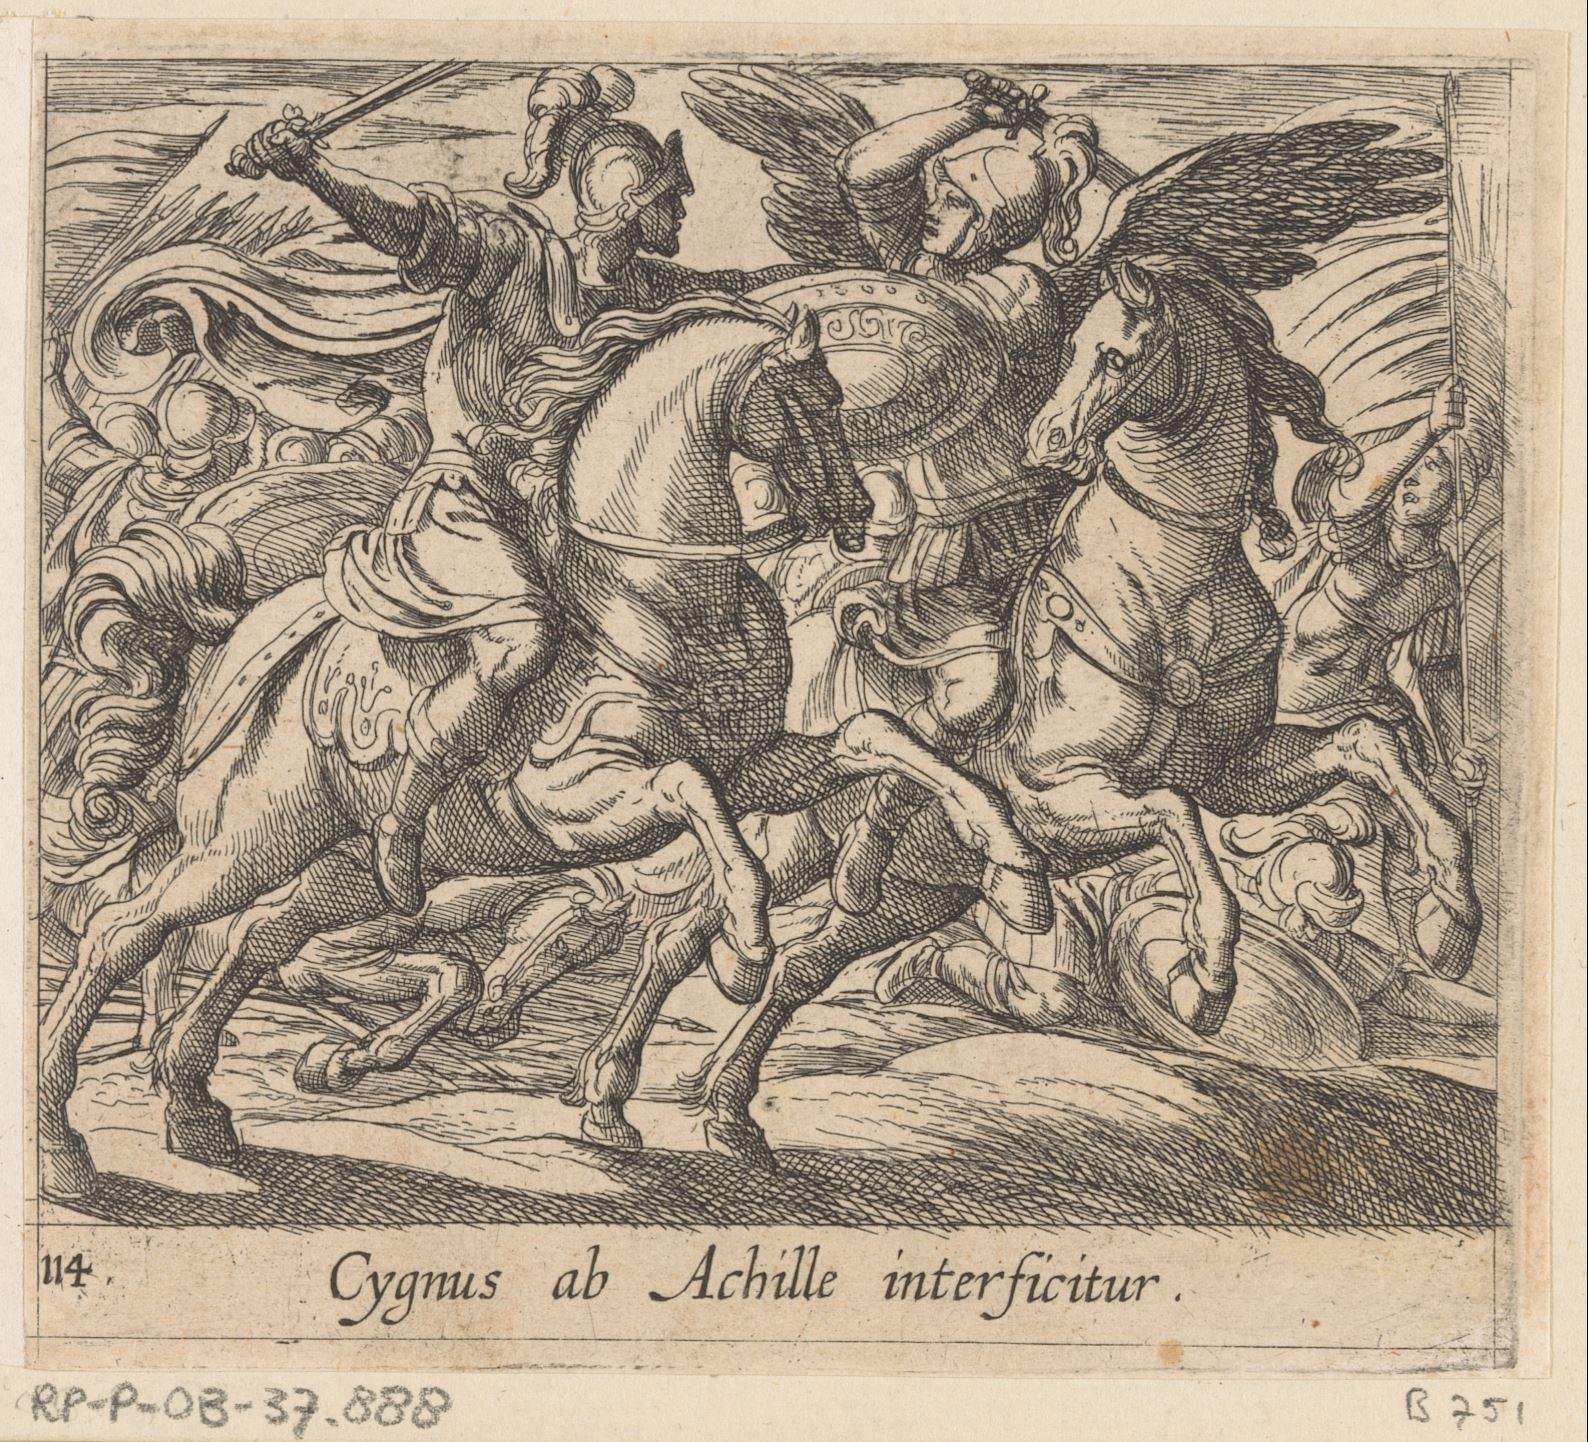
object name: print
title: Achilles vecht met Cygnus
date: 1606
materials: paper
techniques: etching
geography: antwerp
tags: battle, (story of) achilles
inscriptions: collector's mark: Lugt 240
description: Deze prent maakt deel uit van een reeks van 150 prenten (+ titelprent) met voorstellingen van de Metamorfosen van Ovidius.